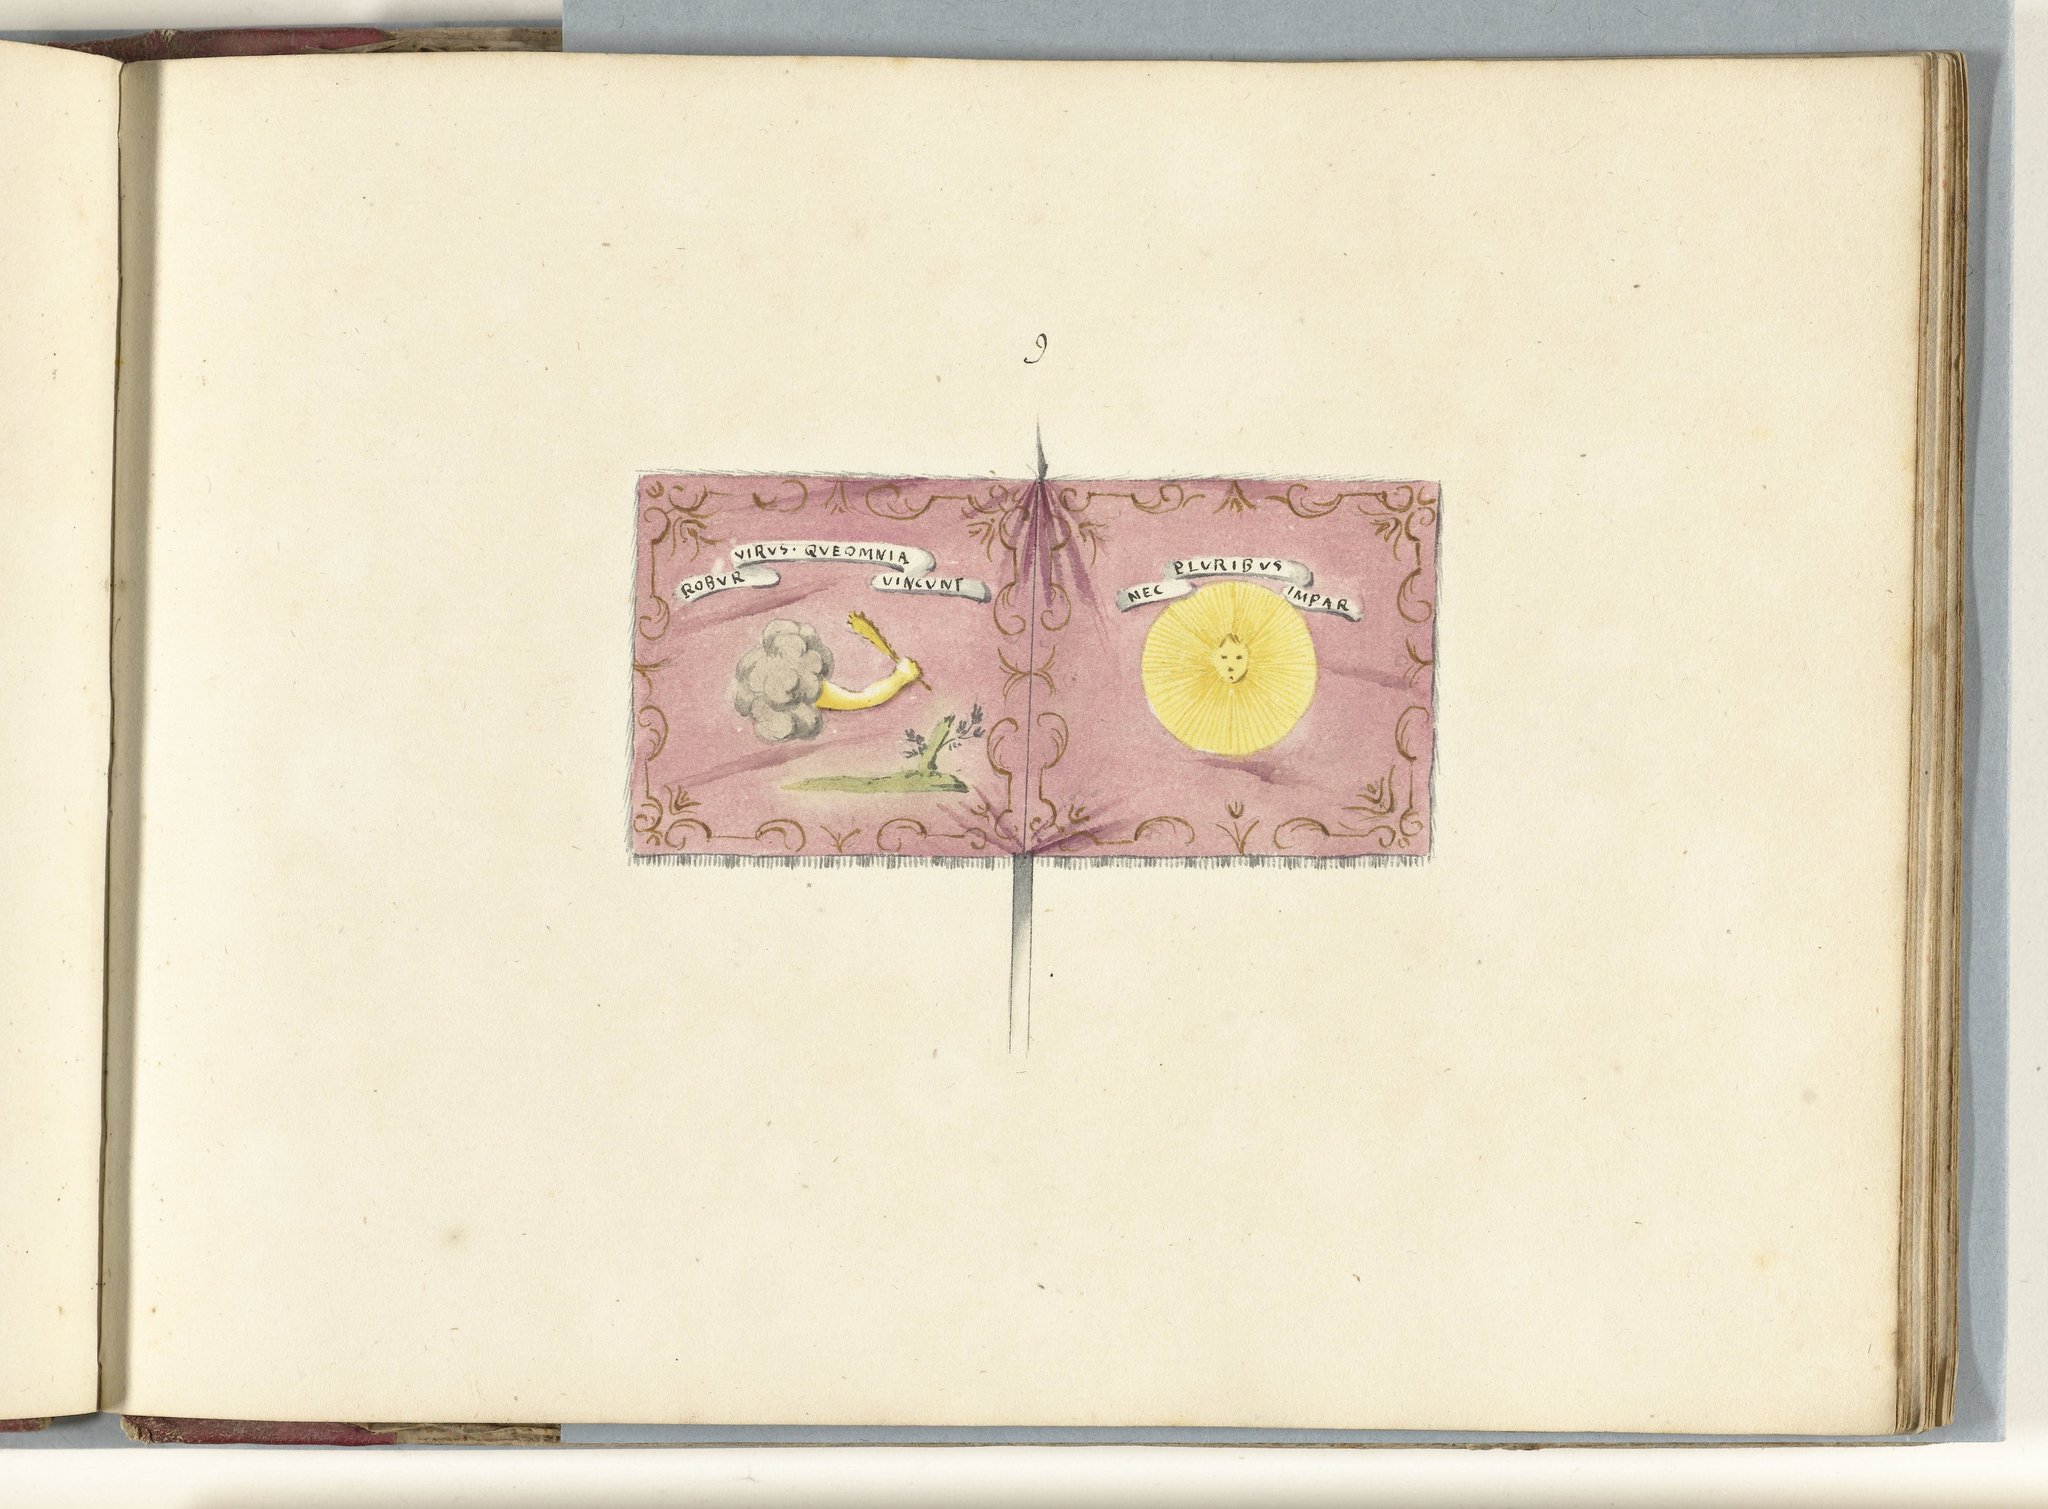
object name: drawing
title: Frans standaard veroverd in de slag bij Malplaquet, 1709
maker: Anonymous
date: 1713-1720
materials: paper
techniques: drawing, writing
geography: northern netherlands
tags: (military) flags and standards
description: Frans standaard veroverd bij de slag bij Malplaquet in 1709. In het boek met tekeningen van Franse vaandels, standaarden en pauken, veroverd tijdens de Spaanse Successieoorlog (1701-1713).